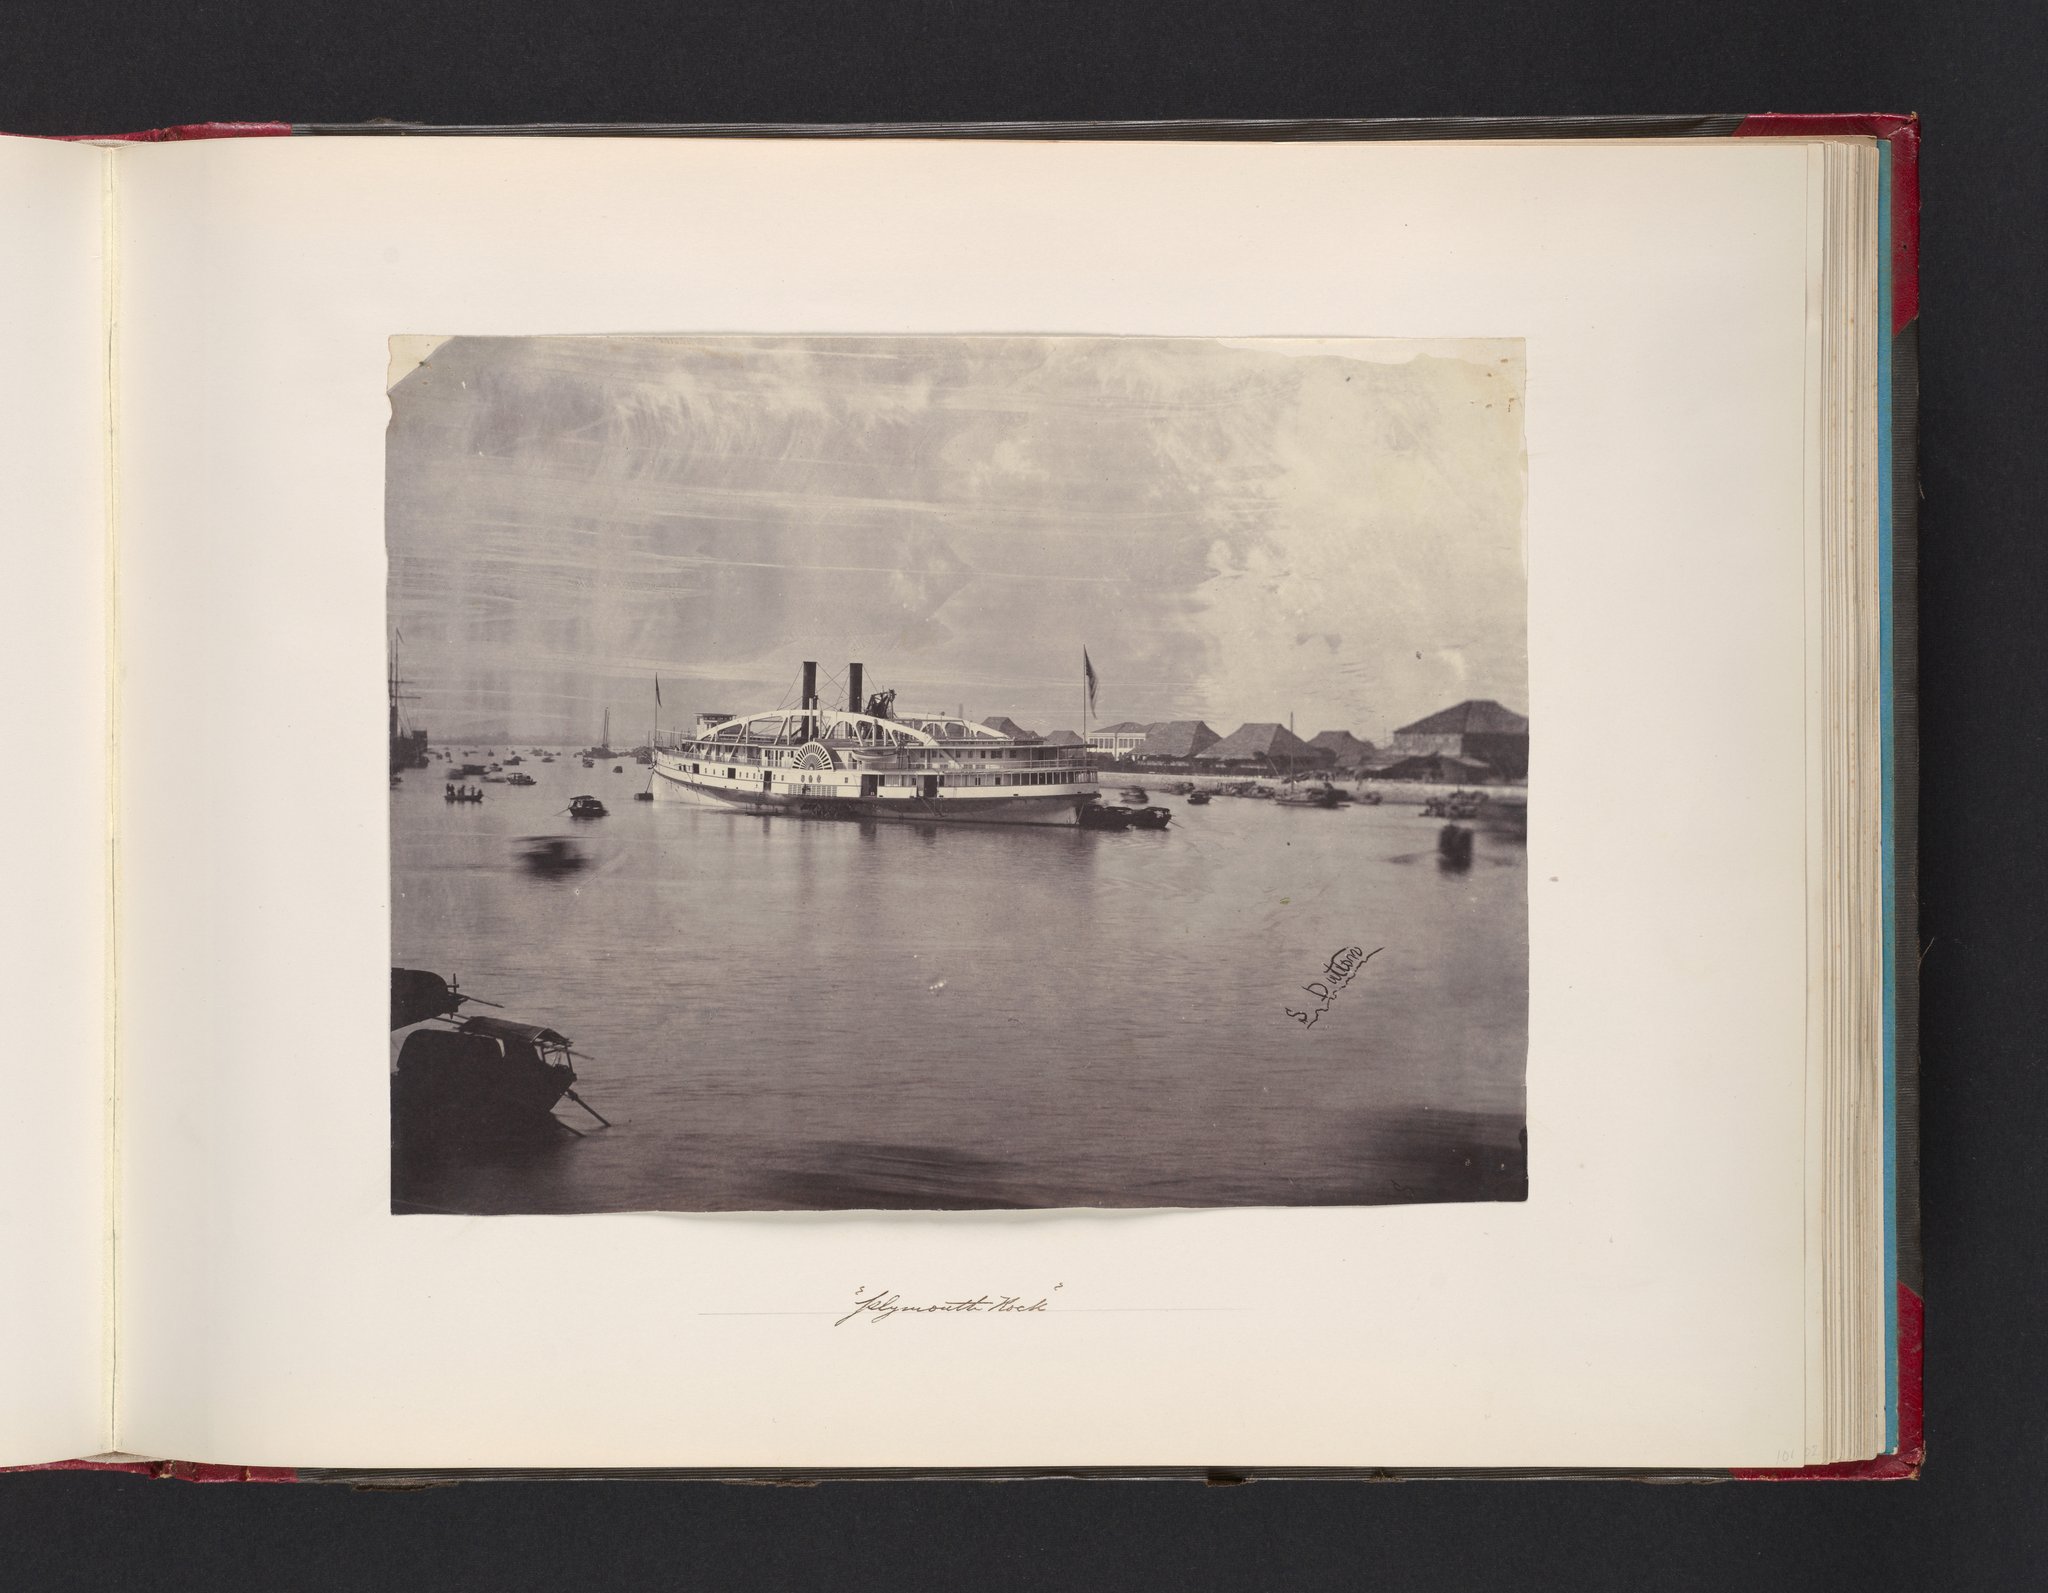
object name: photograph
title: "Plymouth Rock"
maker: john thomson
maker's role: artist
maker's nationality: british, scottish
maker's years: 1837-1921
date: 1865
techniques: albumen silver print, glass negative